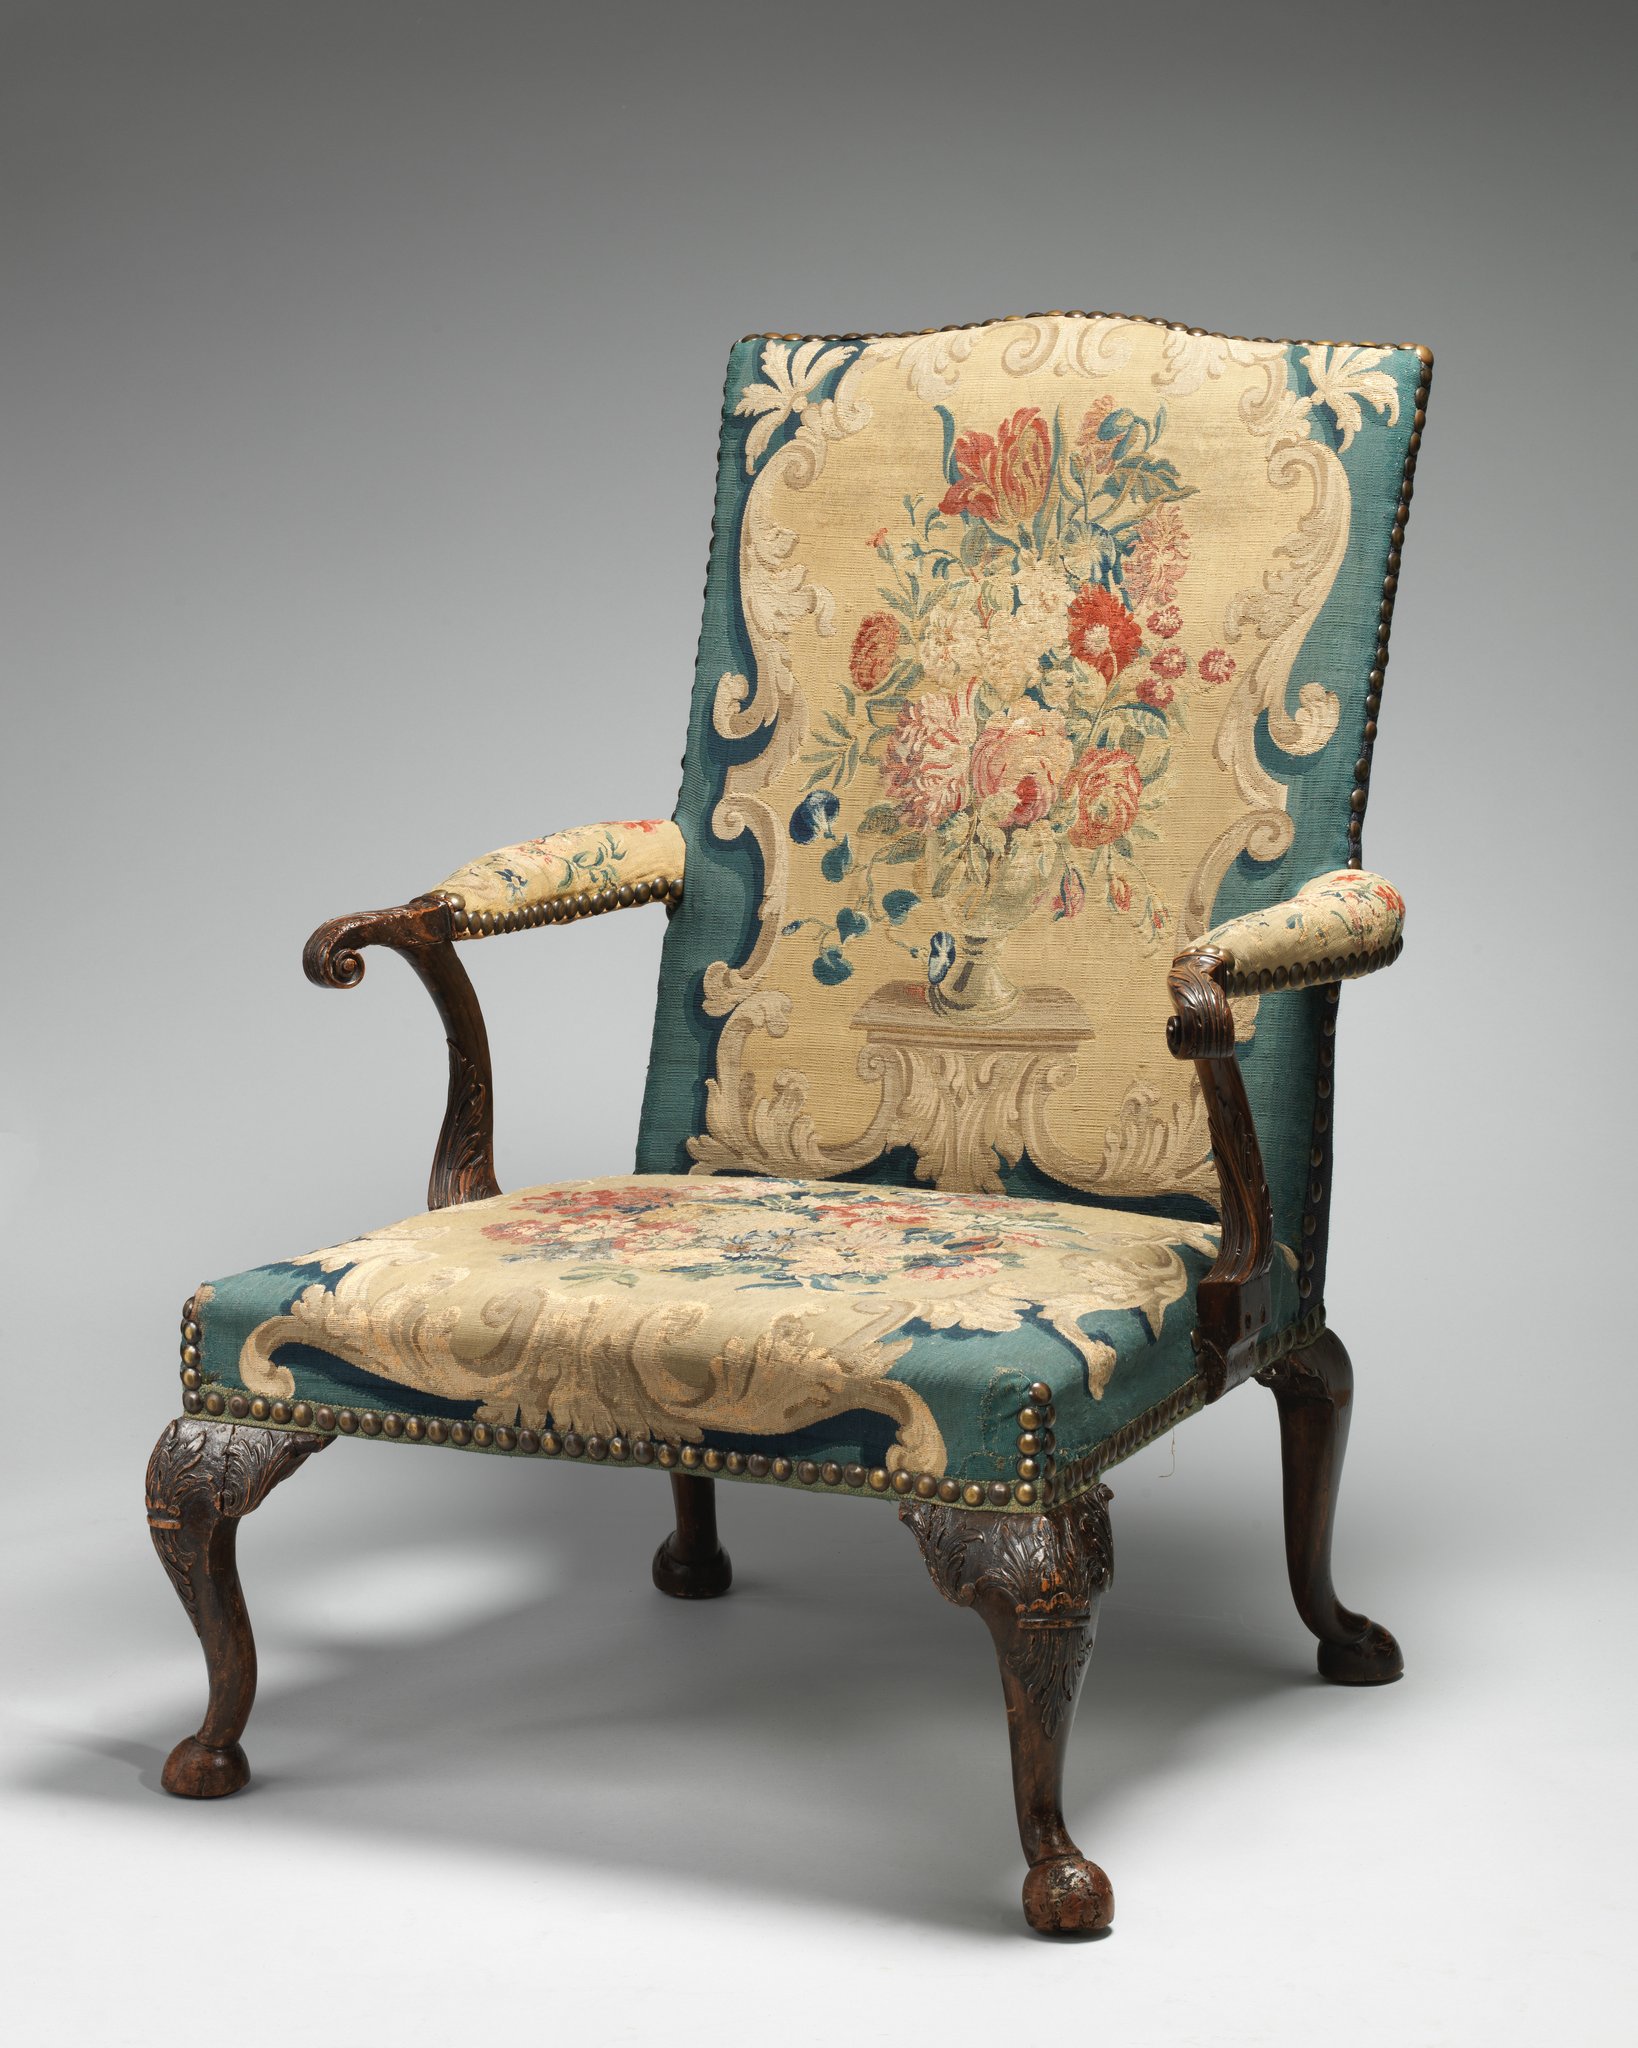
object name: armchair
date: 1740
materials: wood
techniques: tapestry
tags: flowers